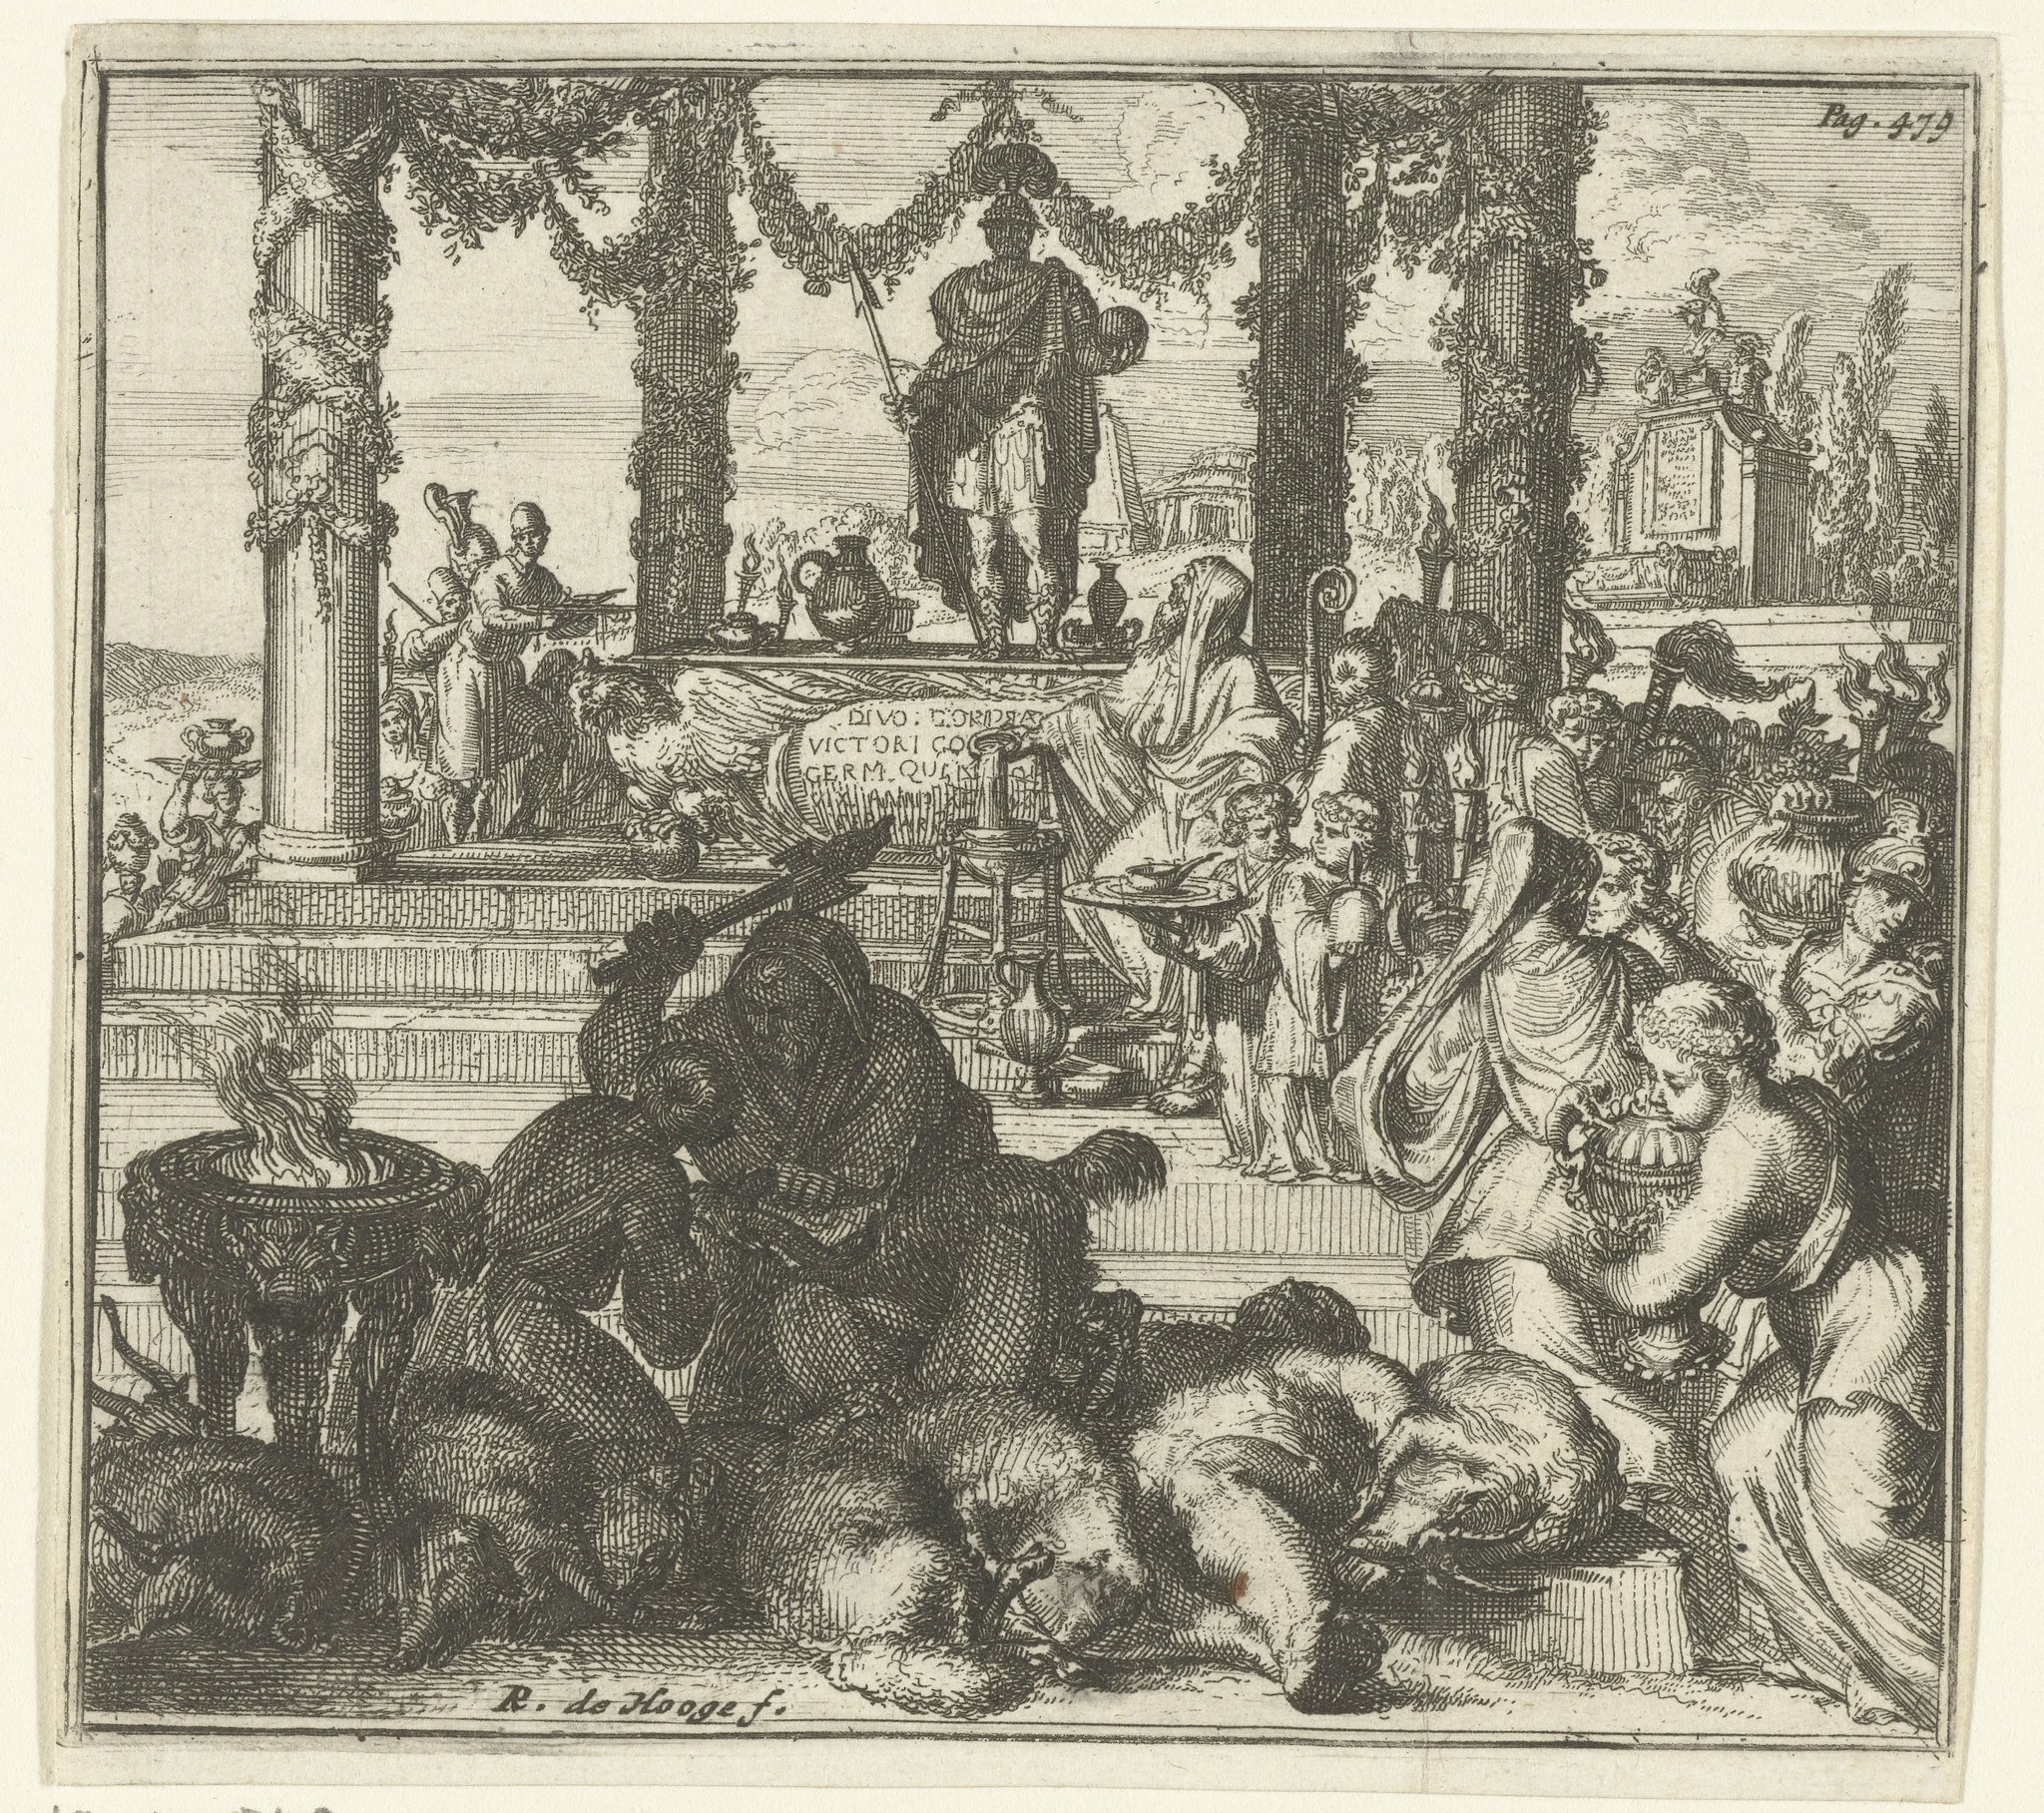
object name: book illustration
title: Romeinen brengen diverse offers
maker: romeyn de hooghe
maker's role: draughtsman, goldsmith, painter, print maker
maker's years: 1645-1708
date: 1672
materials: paper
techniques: etching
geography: netherlands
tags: sacrifice ~ roman religion, funerary ritual, ancestor cult ~ roman religion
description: Romeinen brengen diverse offers ter ere van een veldheer wiens grafmonument met standbeeld op de achtergrond staat. Op de voorgrond liggen enkele geofferde dieren en een dode man.